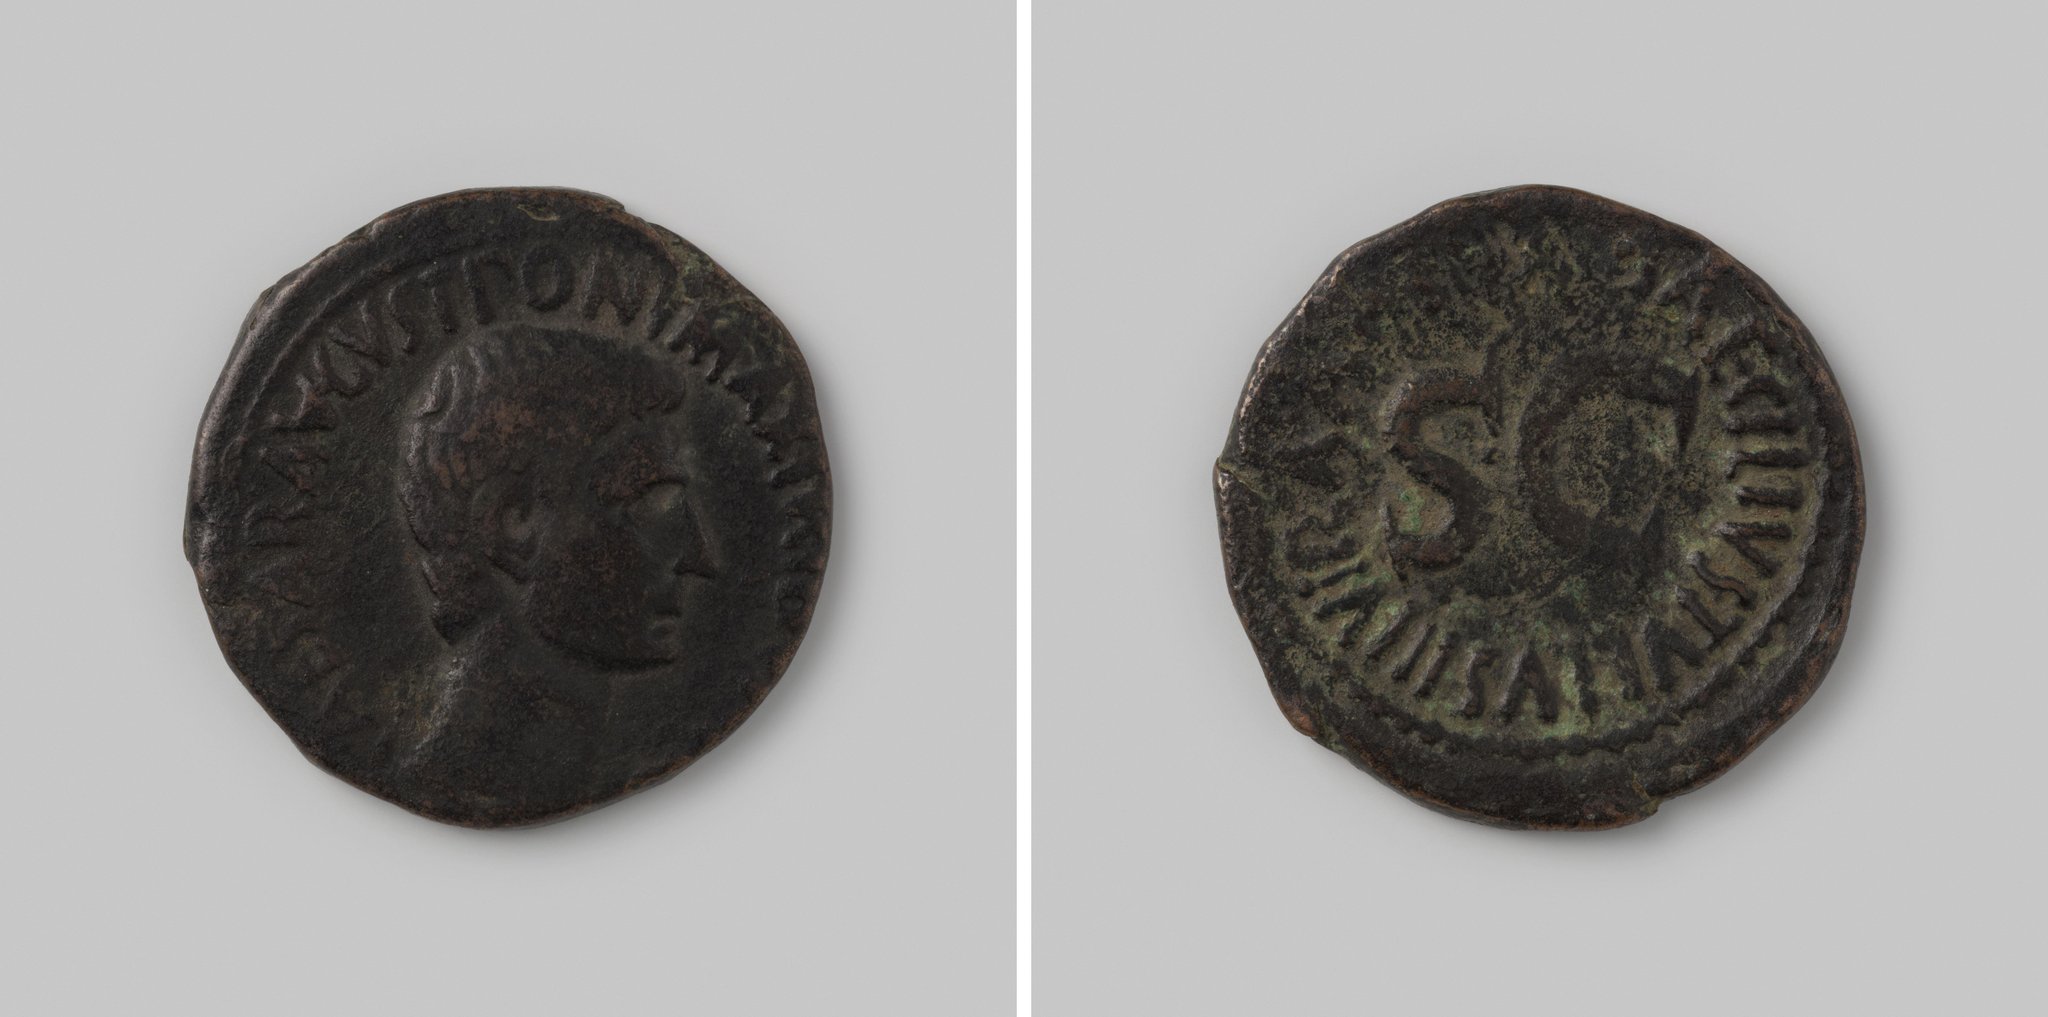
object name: a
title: As uit het Romeinse Keizerrijk van Augustus, -7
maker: marcus maecilius tullus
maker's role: muntmaker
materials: bronze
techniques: striking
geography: rome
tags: marcus maecilius tullus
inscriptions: inscription: ‘SC’, circumscription: ‘M MAECILIVS TVLLVS III VIR A A A FF’, circumscription: ‘CAESAR AVGVST PONT MAX TRIB[VNIC]’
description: Bronzen as. Voorzijde: hoofd van de keizer naar rechts. Keerzijde: In het veld de letters S en C. In het omschrift de naam van Marcus Maecilius Tullus, muntmeester in het jaar -7.